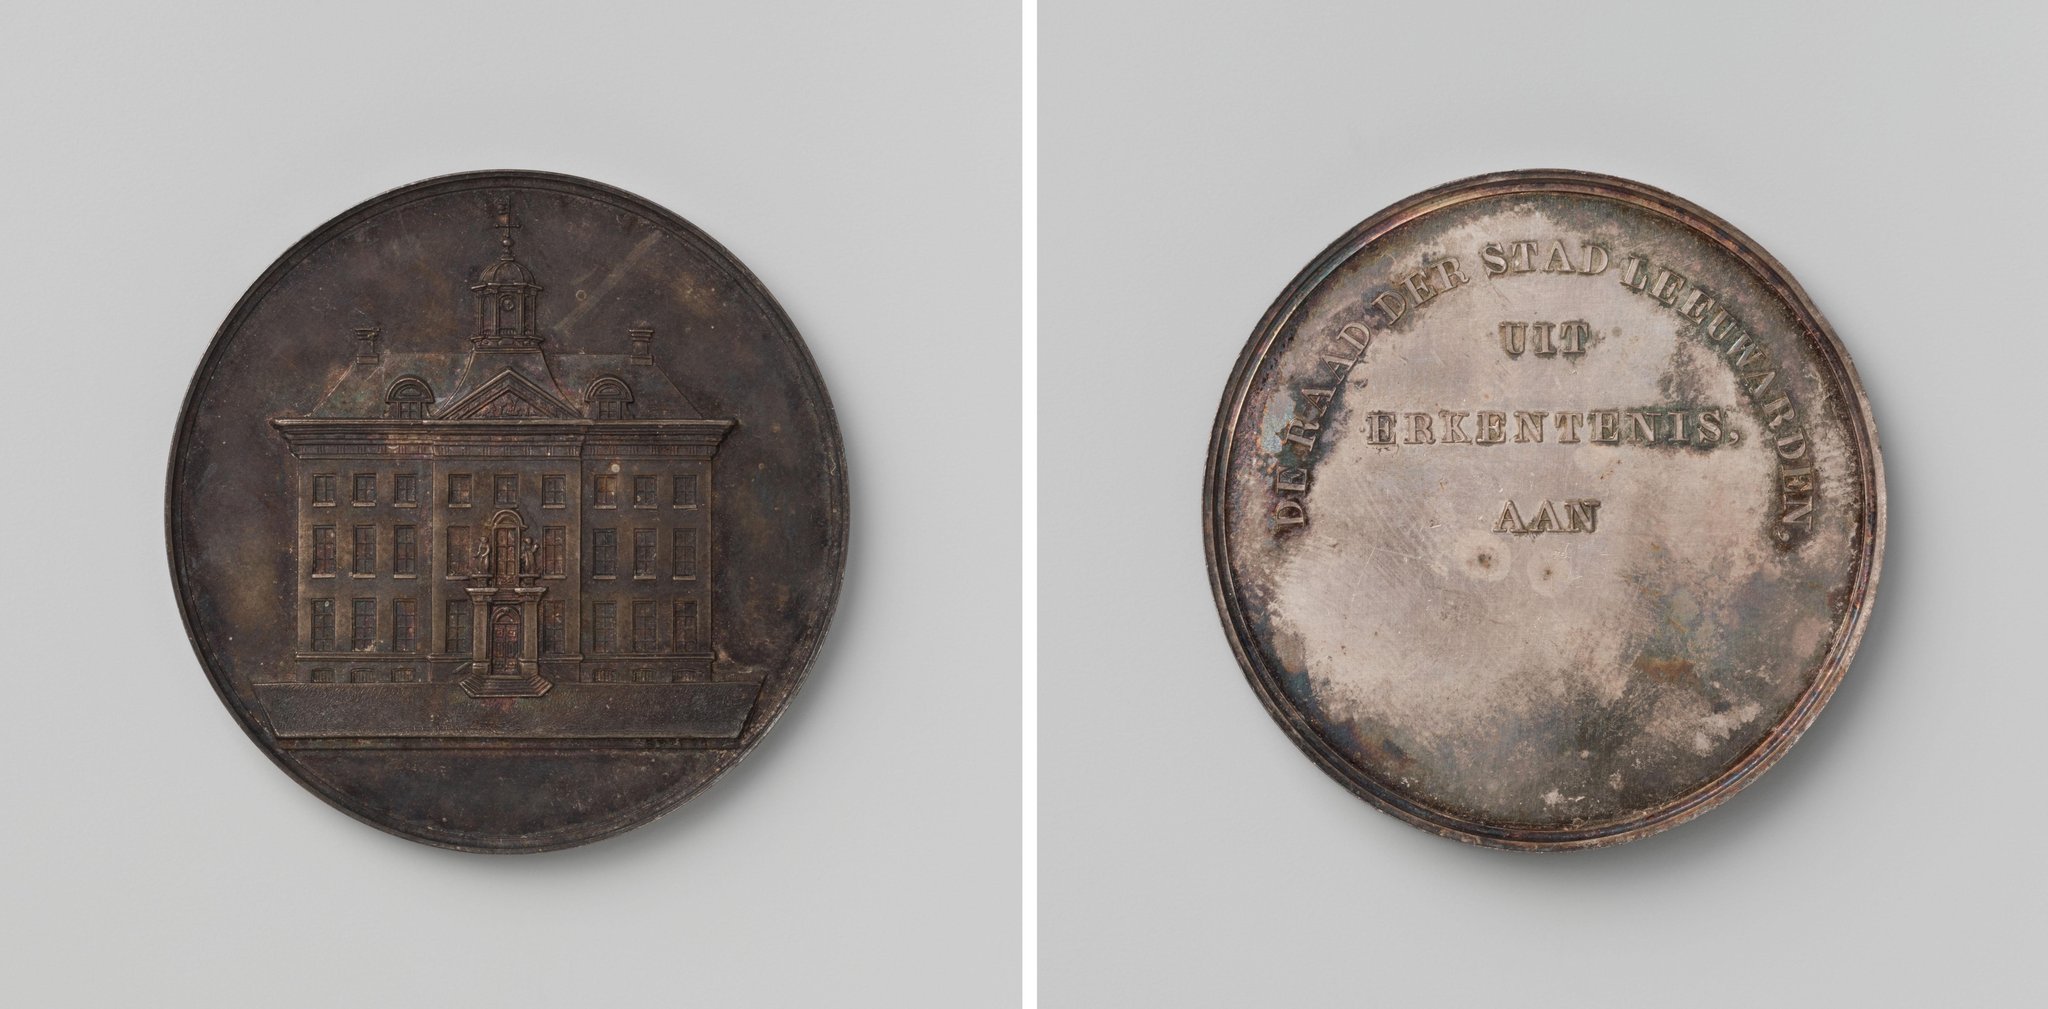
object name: honorary medal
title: Stad Leeuwarden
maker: tjeerd keikes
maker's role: medailleur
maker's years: 1804-1886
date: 1836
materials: silver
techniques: striking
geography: leeuwarden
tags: leeuwarden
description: Zilveren penning. Voorzijde: gezicht op stadhuis van Leeuwarden. Keerzijde: opschrift boven blanco veld binnen omschrift